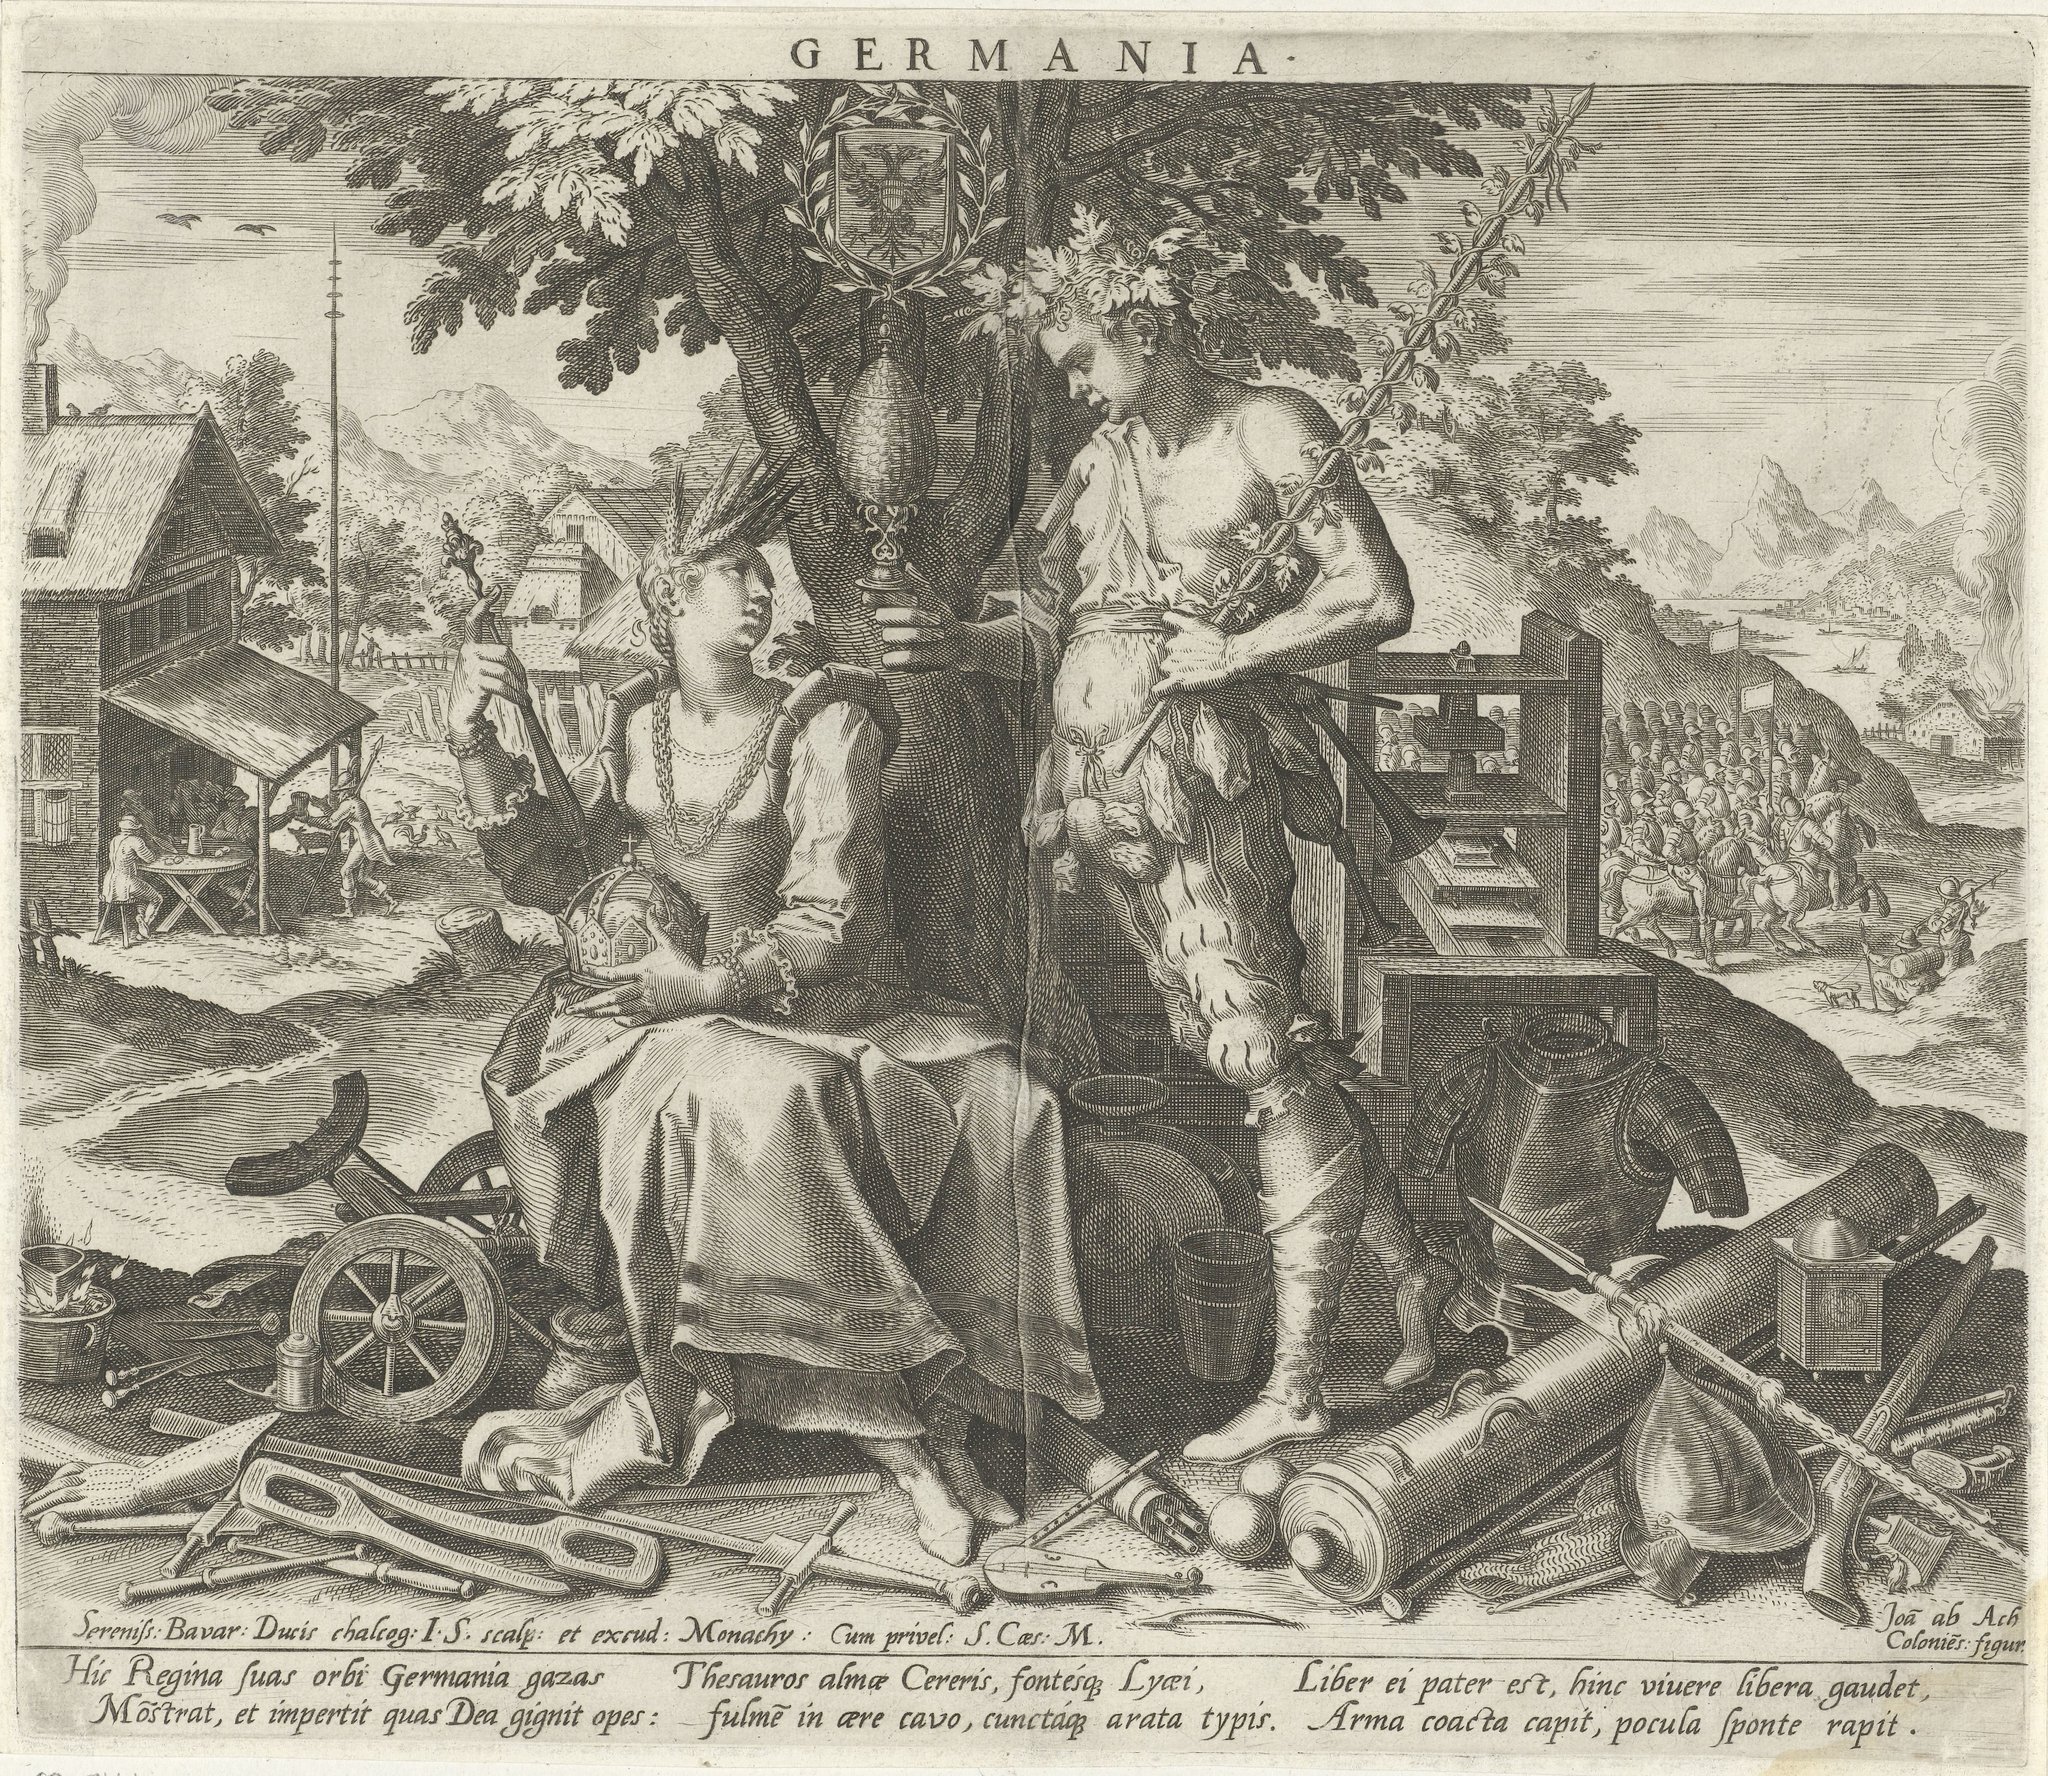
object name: print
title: Allegorische voorstellingen van Europese landen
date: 1588-1595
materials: paper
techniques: engraving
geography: cologne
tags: army 'en route', (story of) ceres (demeter), (story of) bacchus (dionysus), liber, personifications of countries, nations, states, districts, etc., farmers, pavement, terrace in front of inn or restaurant, celebration meal, feast, banquet, germany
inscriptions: collector's mark: Lugt 240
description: Een allegorie op Duitsland. In het midden onder een boom de goden Ceres (landbouw) en Bacchus (wijn). Ceres houdt een scepter in de handen. Op haar schoot de Duitse keizerskroon. Bacchus heeft de rijksappel en een wijnrank vast. Rondom hen op de grond liggen wapentuig en landbouwwerktuigen. Achter hen een drukpers. Op de achtergrond rechts feestende boeren, links een leger. De prent maakt deel uit van een vierdelige serie met allegorische voorstellingen van Europese landen.